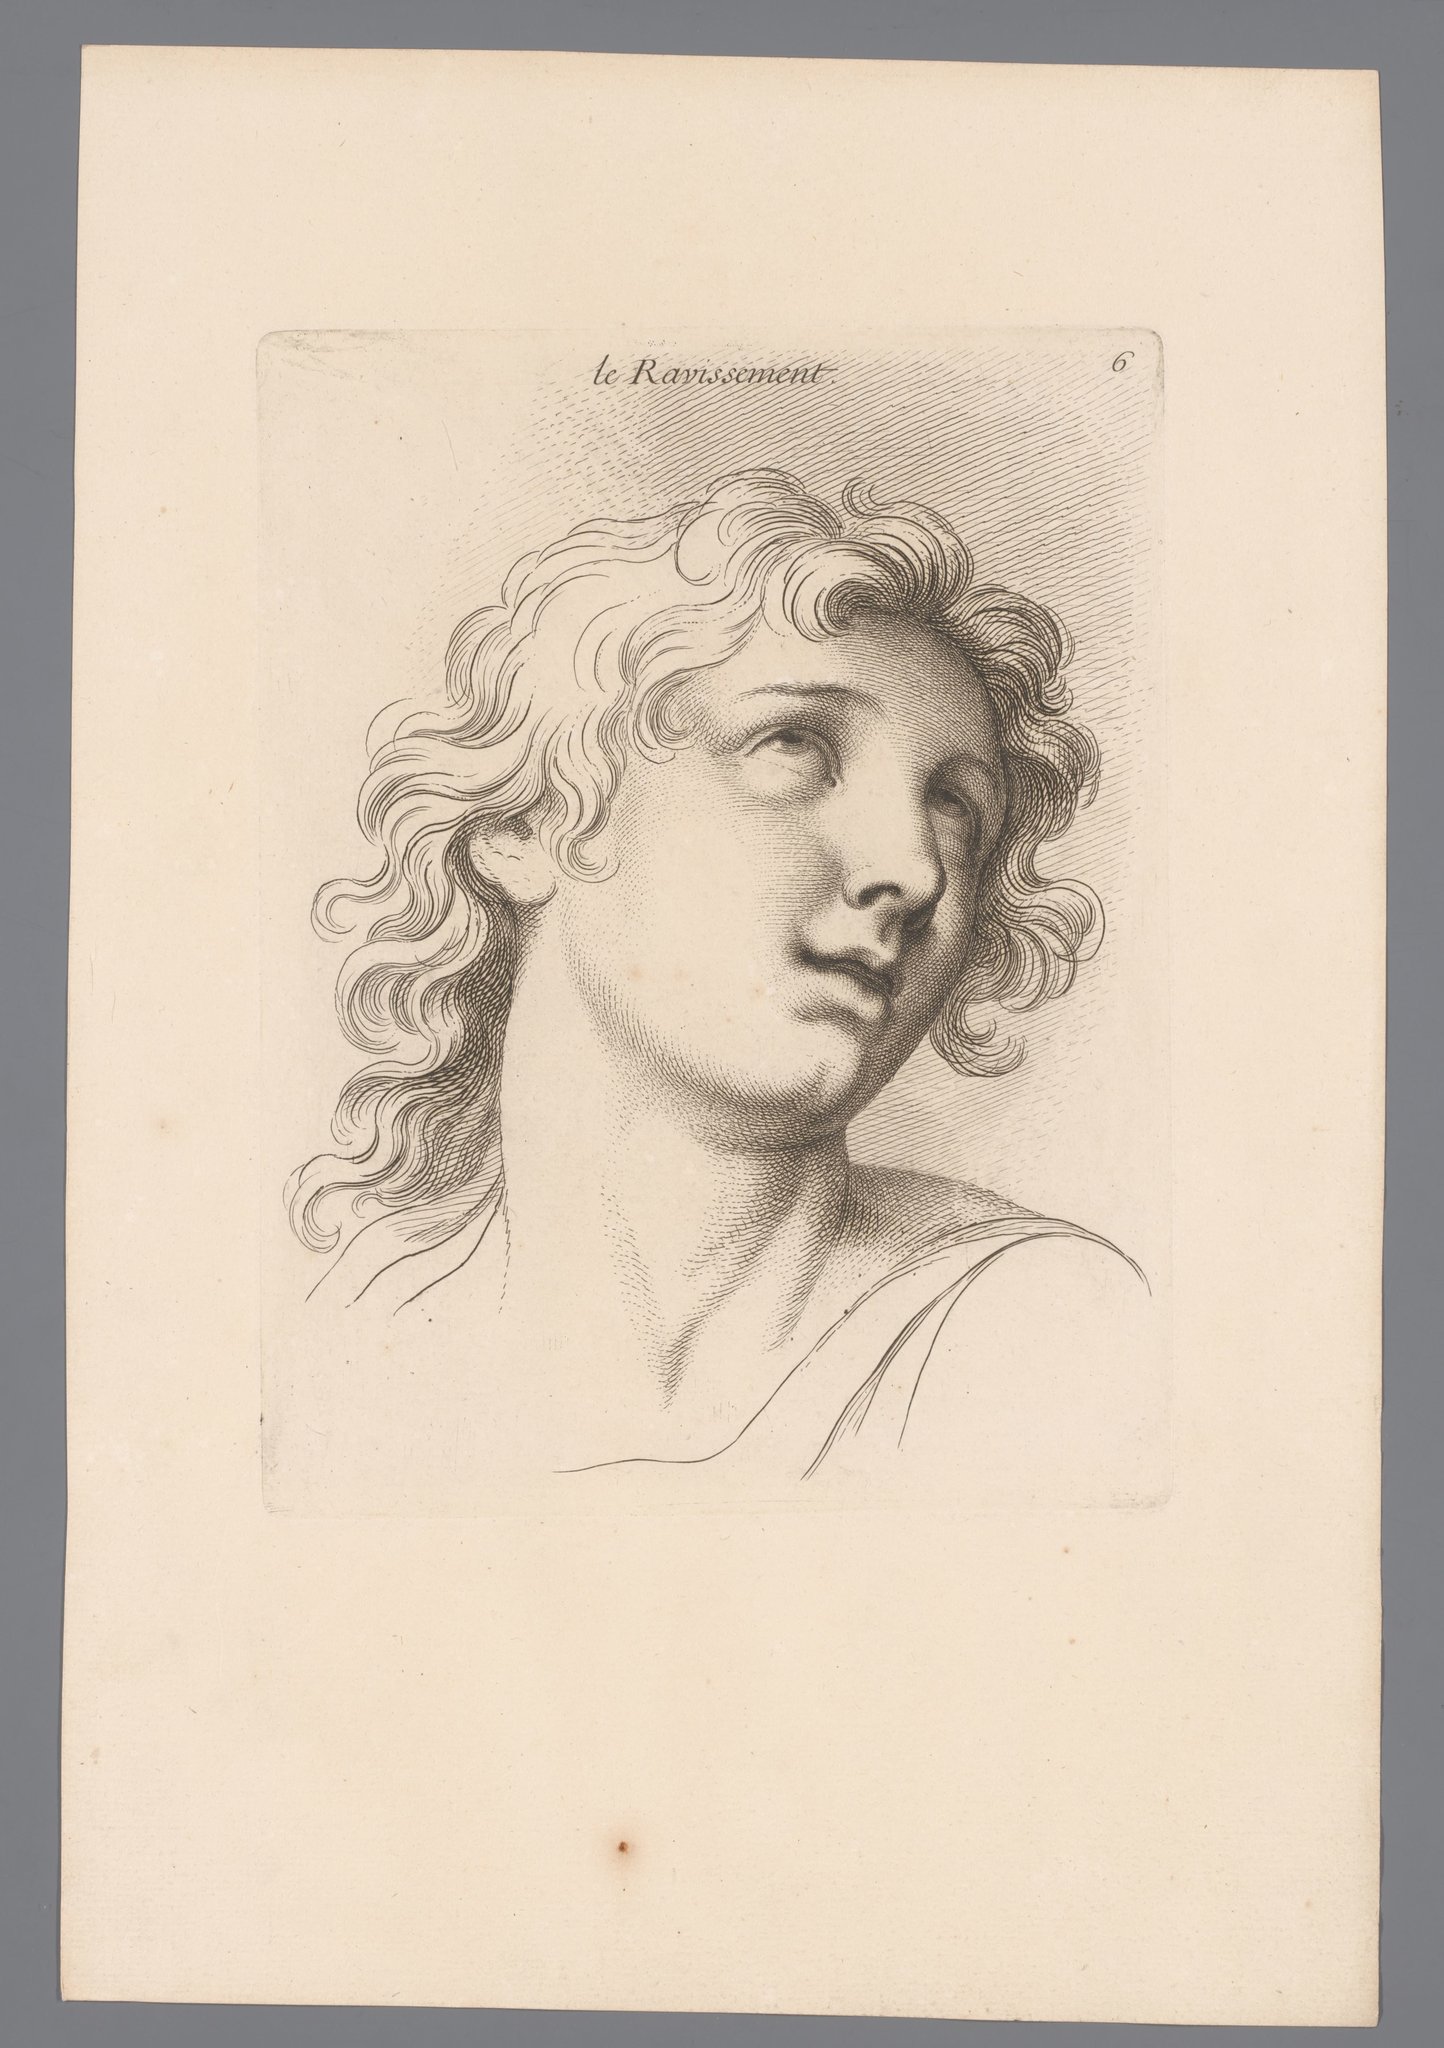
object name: book illustration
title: Le ravissement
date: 1727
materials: paper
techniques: etching, intaglio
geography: paris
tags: ecstasy, spiritual exaltation, rapture, morphology of facial expression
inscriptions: collector's mark: Lugt 2228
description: Prent uit: Le Brun, Charles. Les expressions des passions de l'âme, représentées en plusieurs testes gravées d'après les dessins de feu M. Le Brun. Parijs: Jean Audran, 1727.